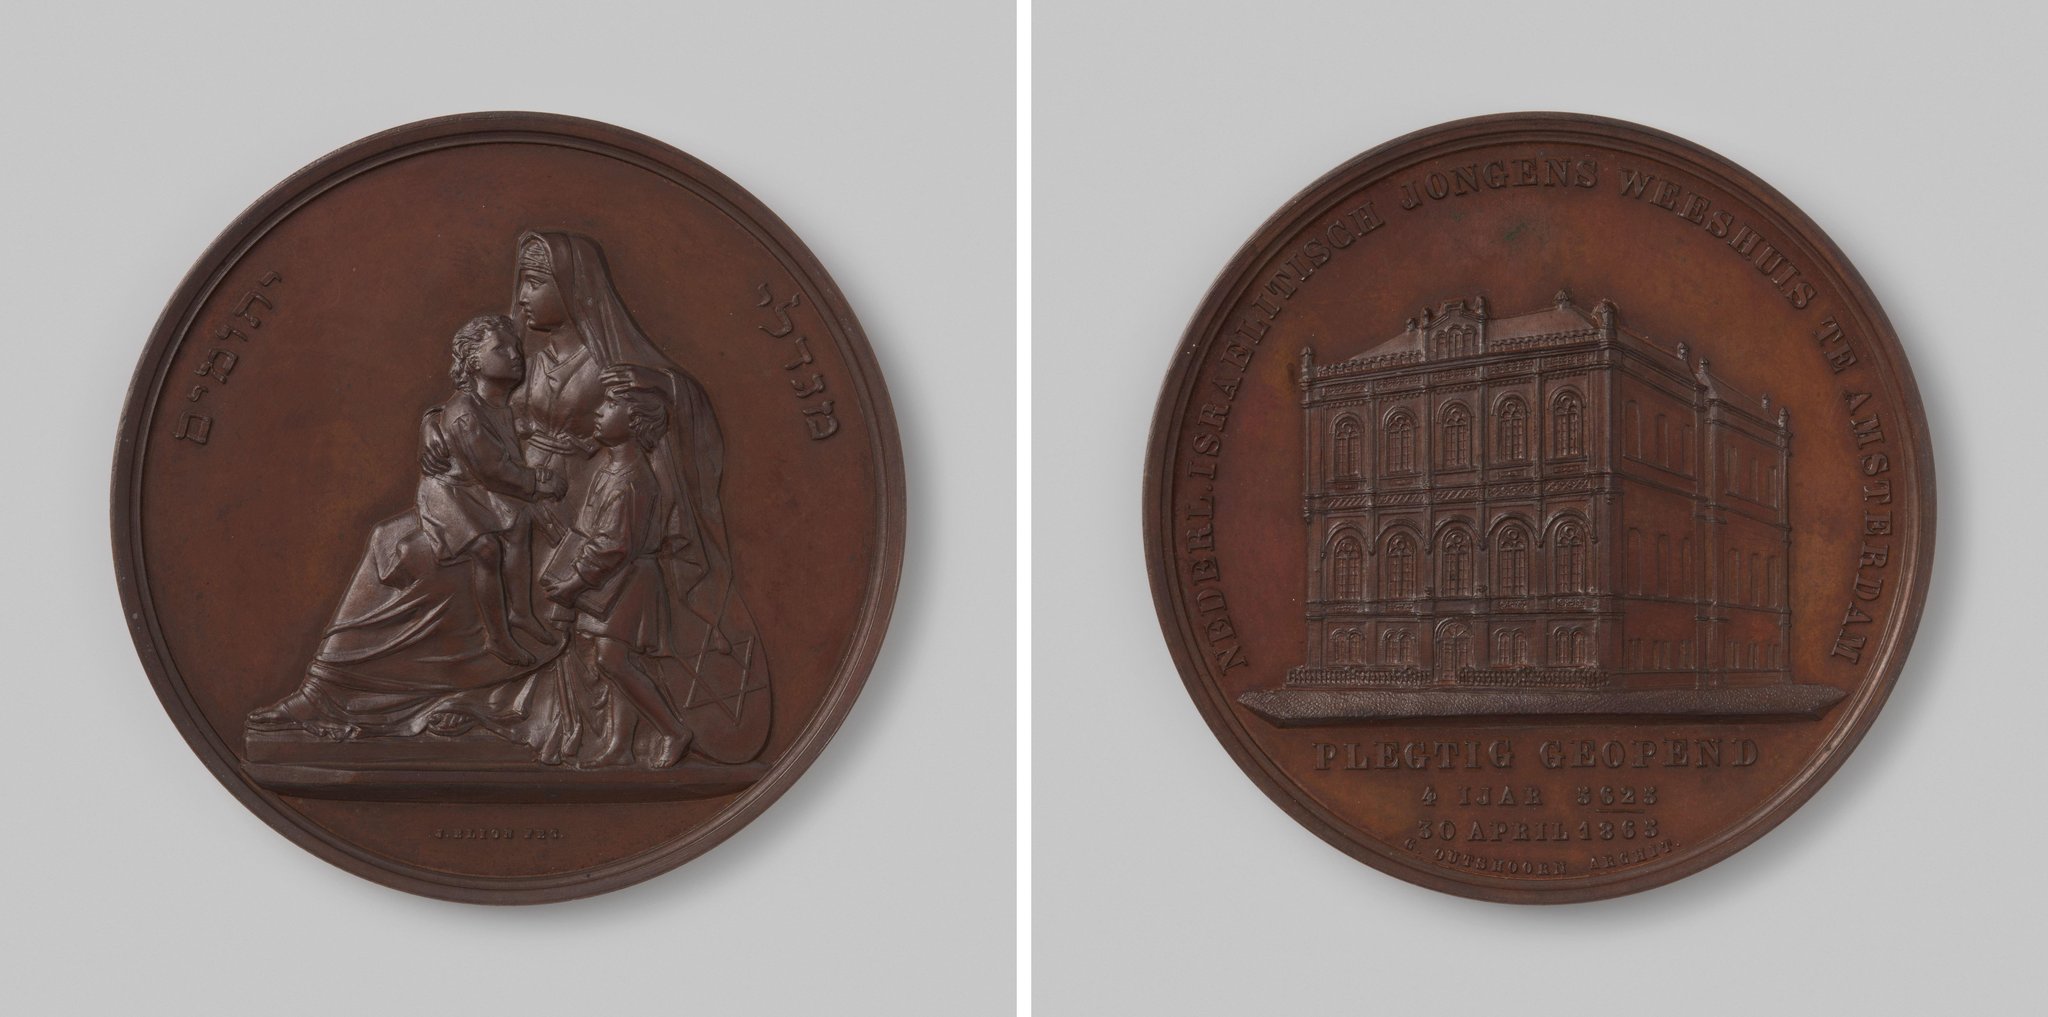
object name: history medal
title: Opening van het Nederlandsch Israëlitisch Jongens Weeshuis te Amsterdam 1865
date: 1865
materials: bronze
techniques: striking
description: Bronzen penning, op de voorzijde de Liefdadigheid als zittende vrouw met twee kinderen, met Hebreeuws omschrift , op de keerzijde het aanzien van het weeshuis half van rechts met omschrift en afsnedetekst.